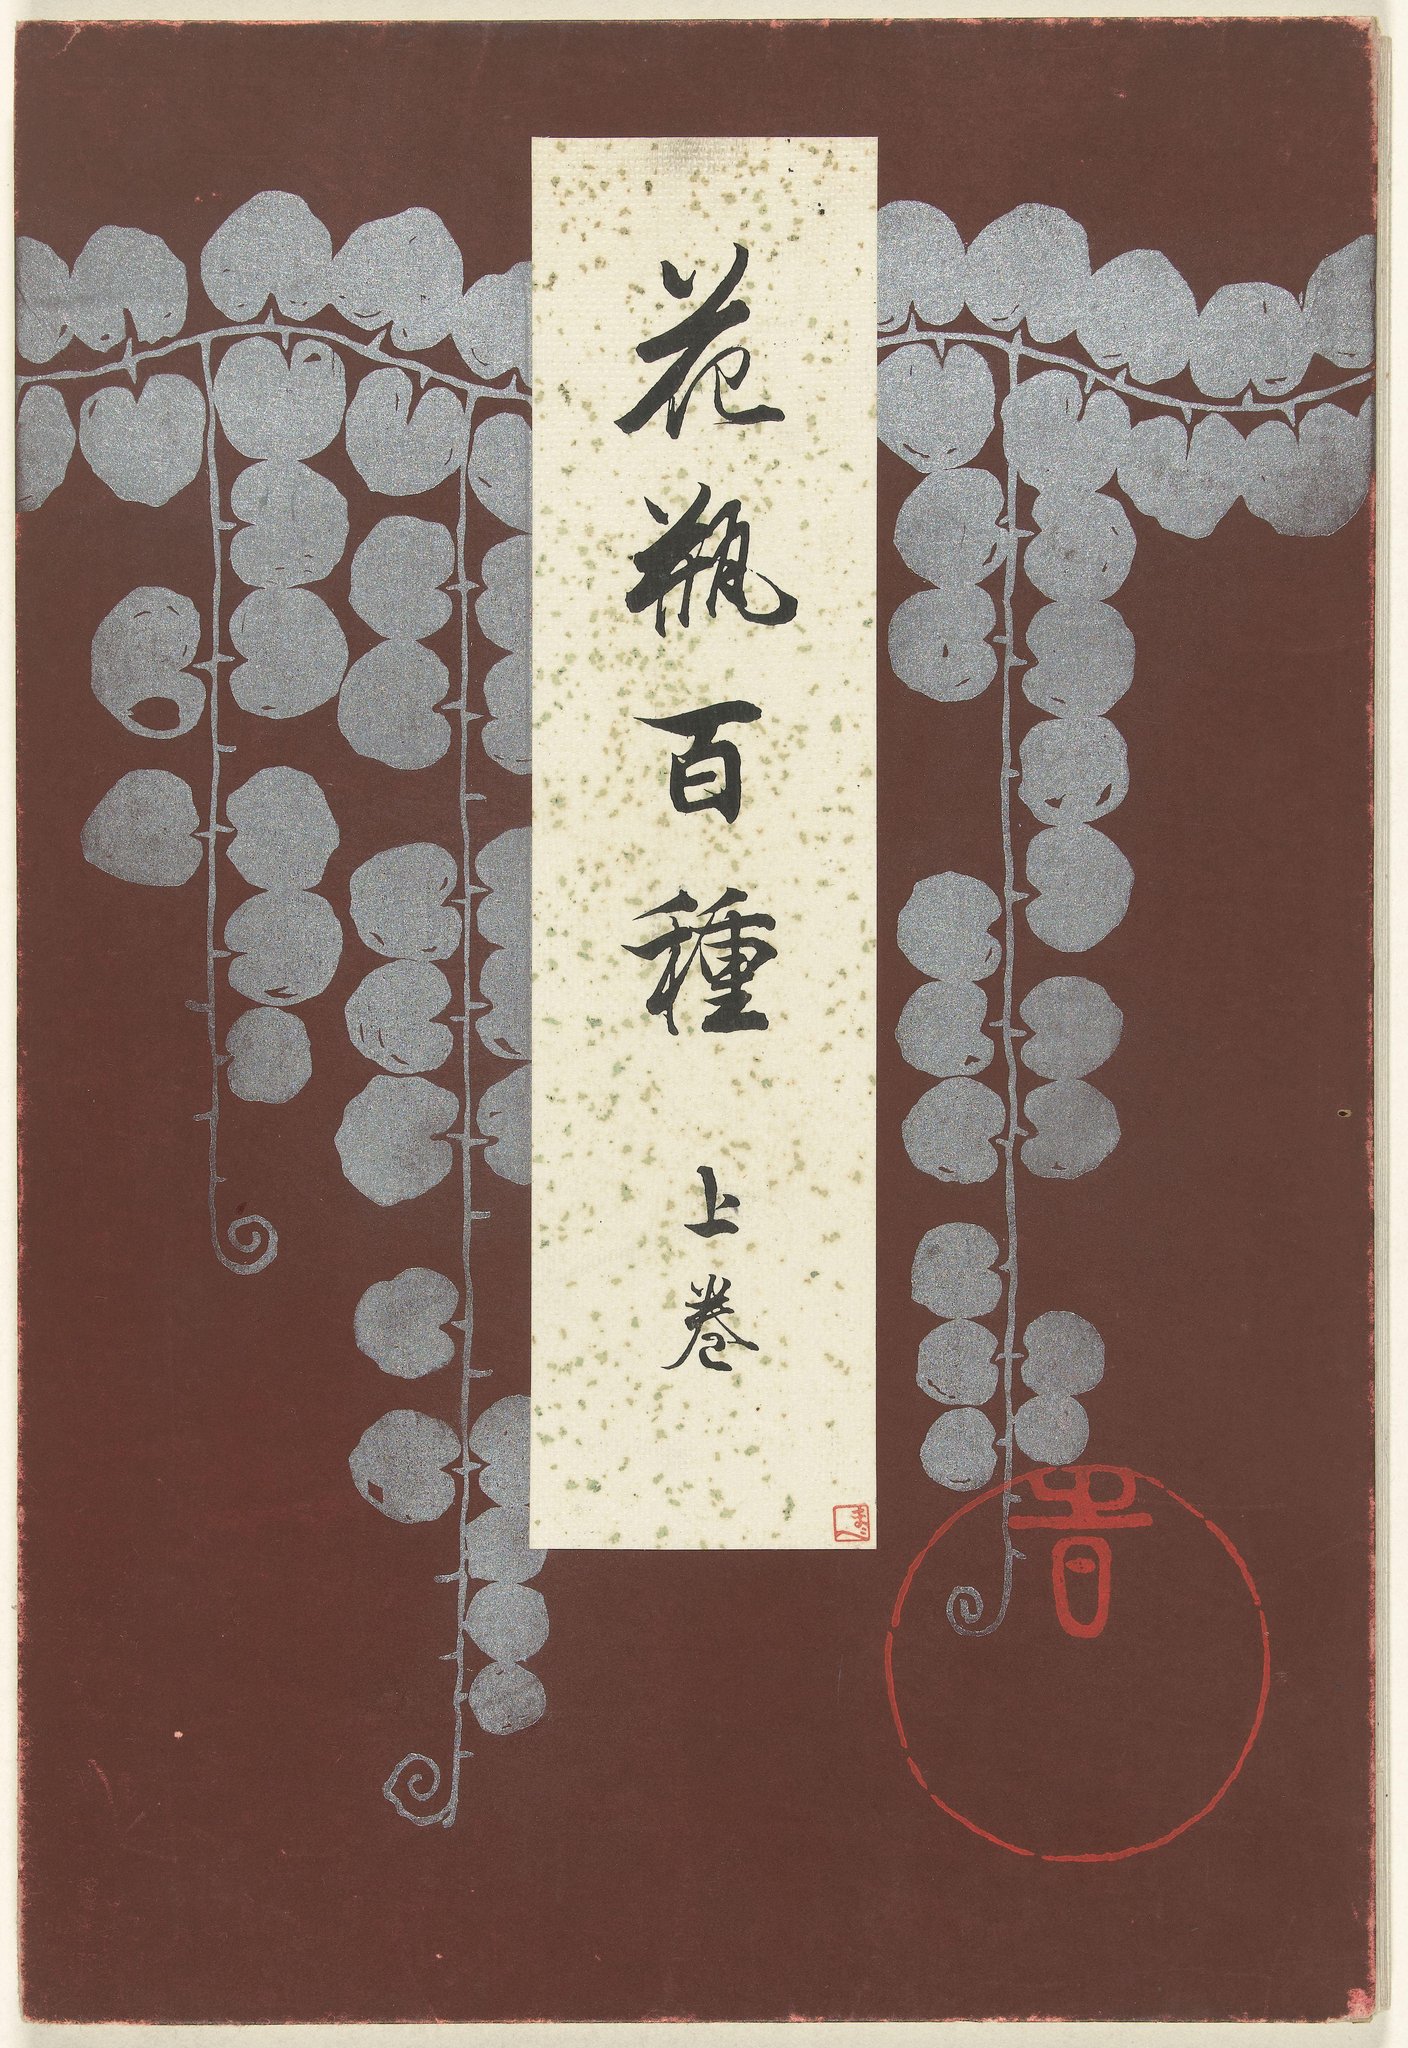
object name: book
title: Honderd vazen - eerste deel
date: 1914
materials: paper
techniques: woodcut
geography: kyoto